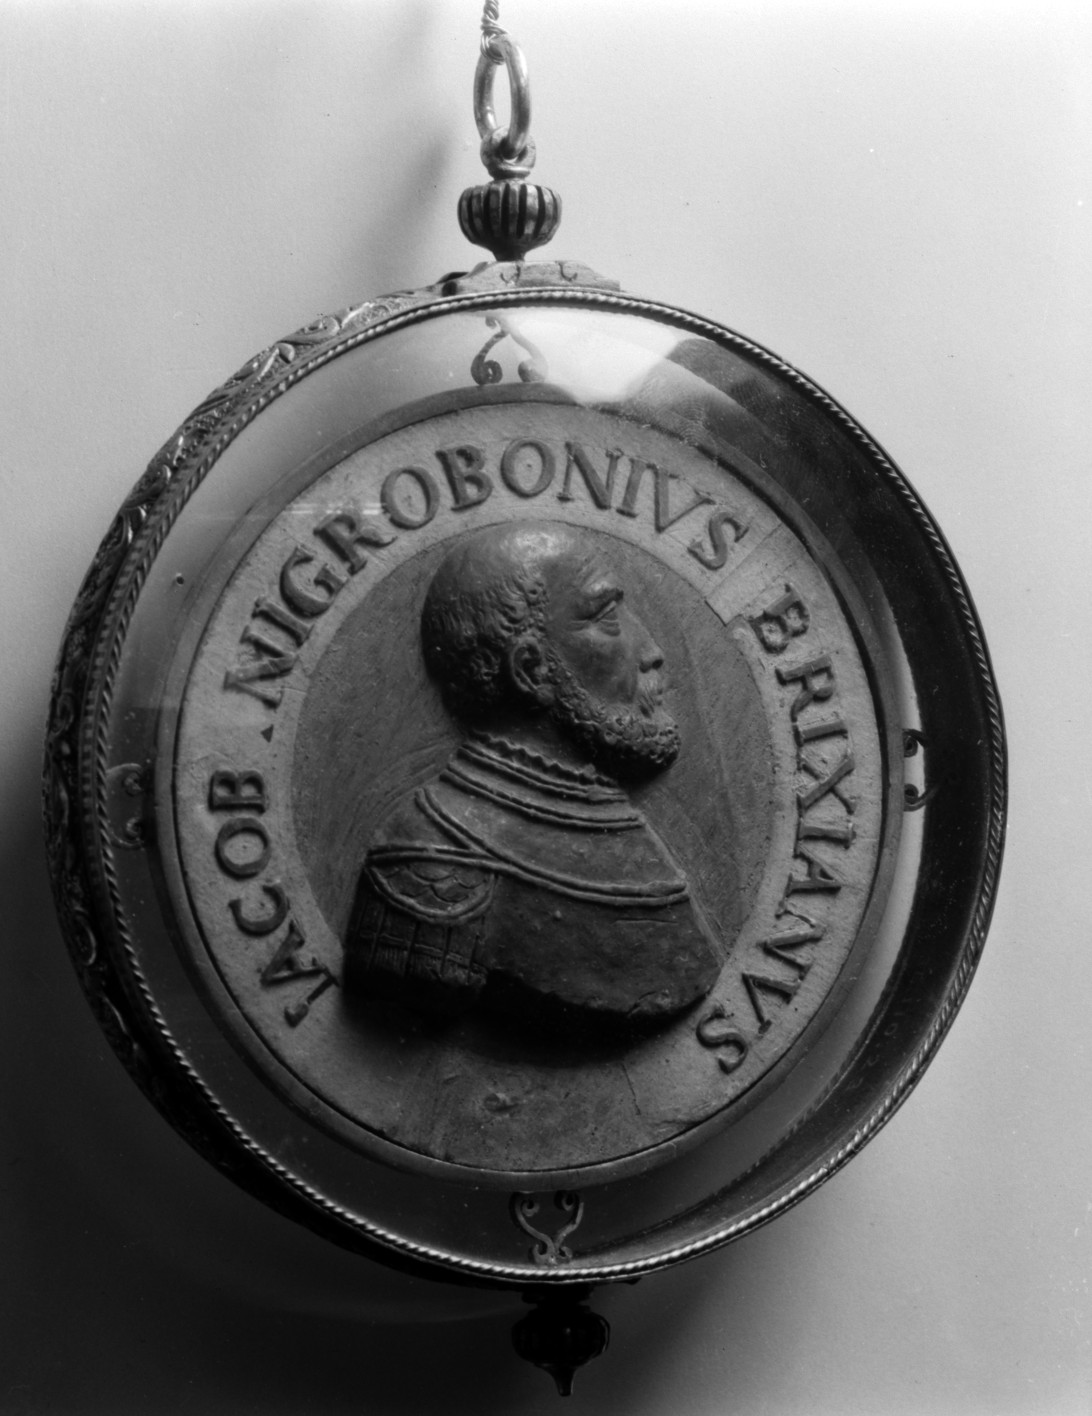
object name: relief model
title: Giacomo Negroboni (da Valtrompia) of Brescia (d. 1527)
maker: fra giulio da brescia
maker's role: artist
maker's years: 1450-1550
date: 1527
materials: parchment, wood, wax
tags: men,women